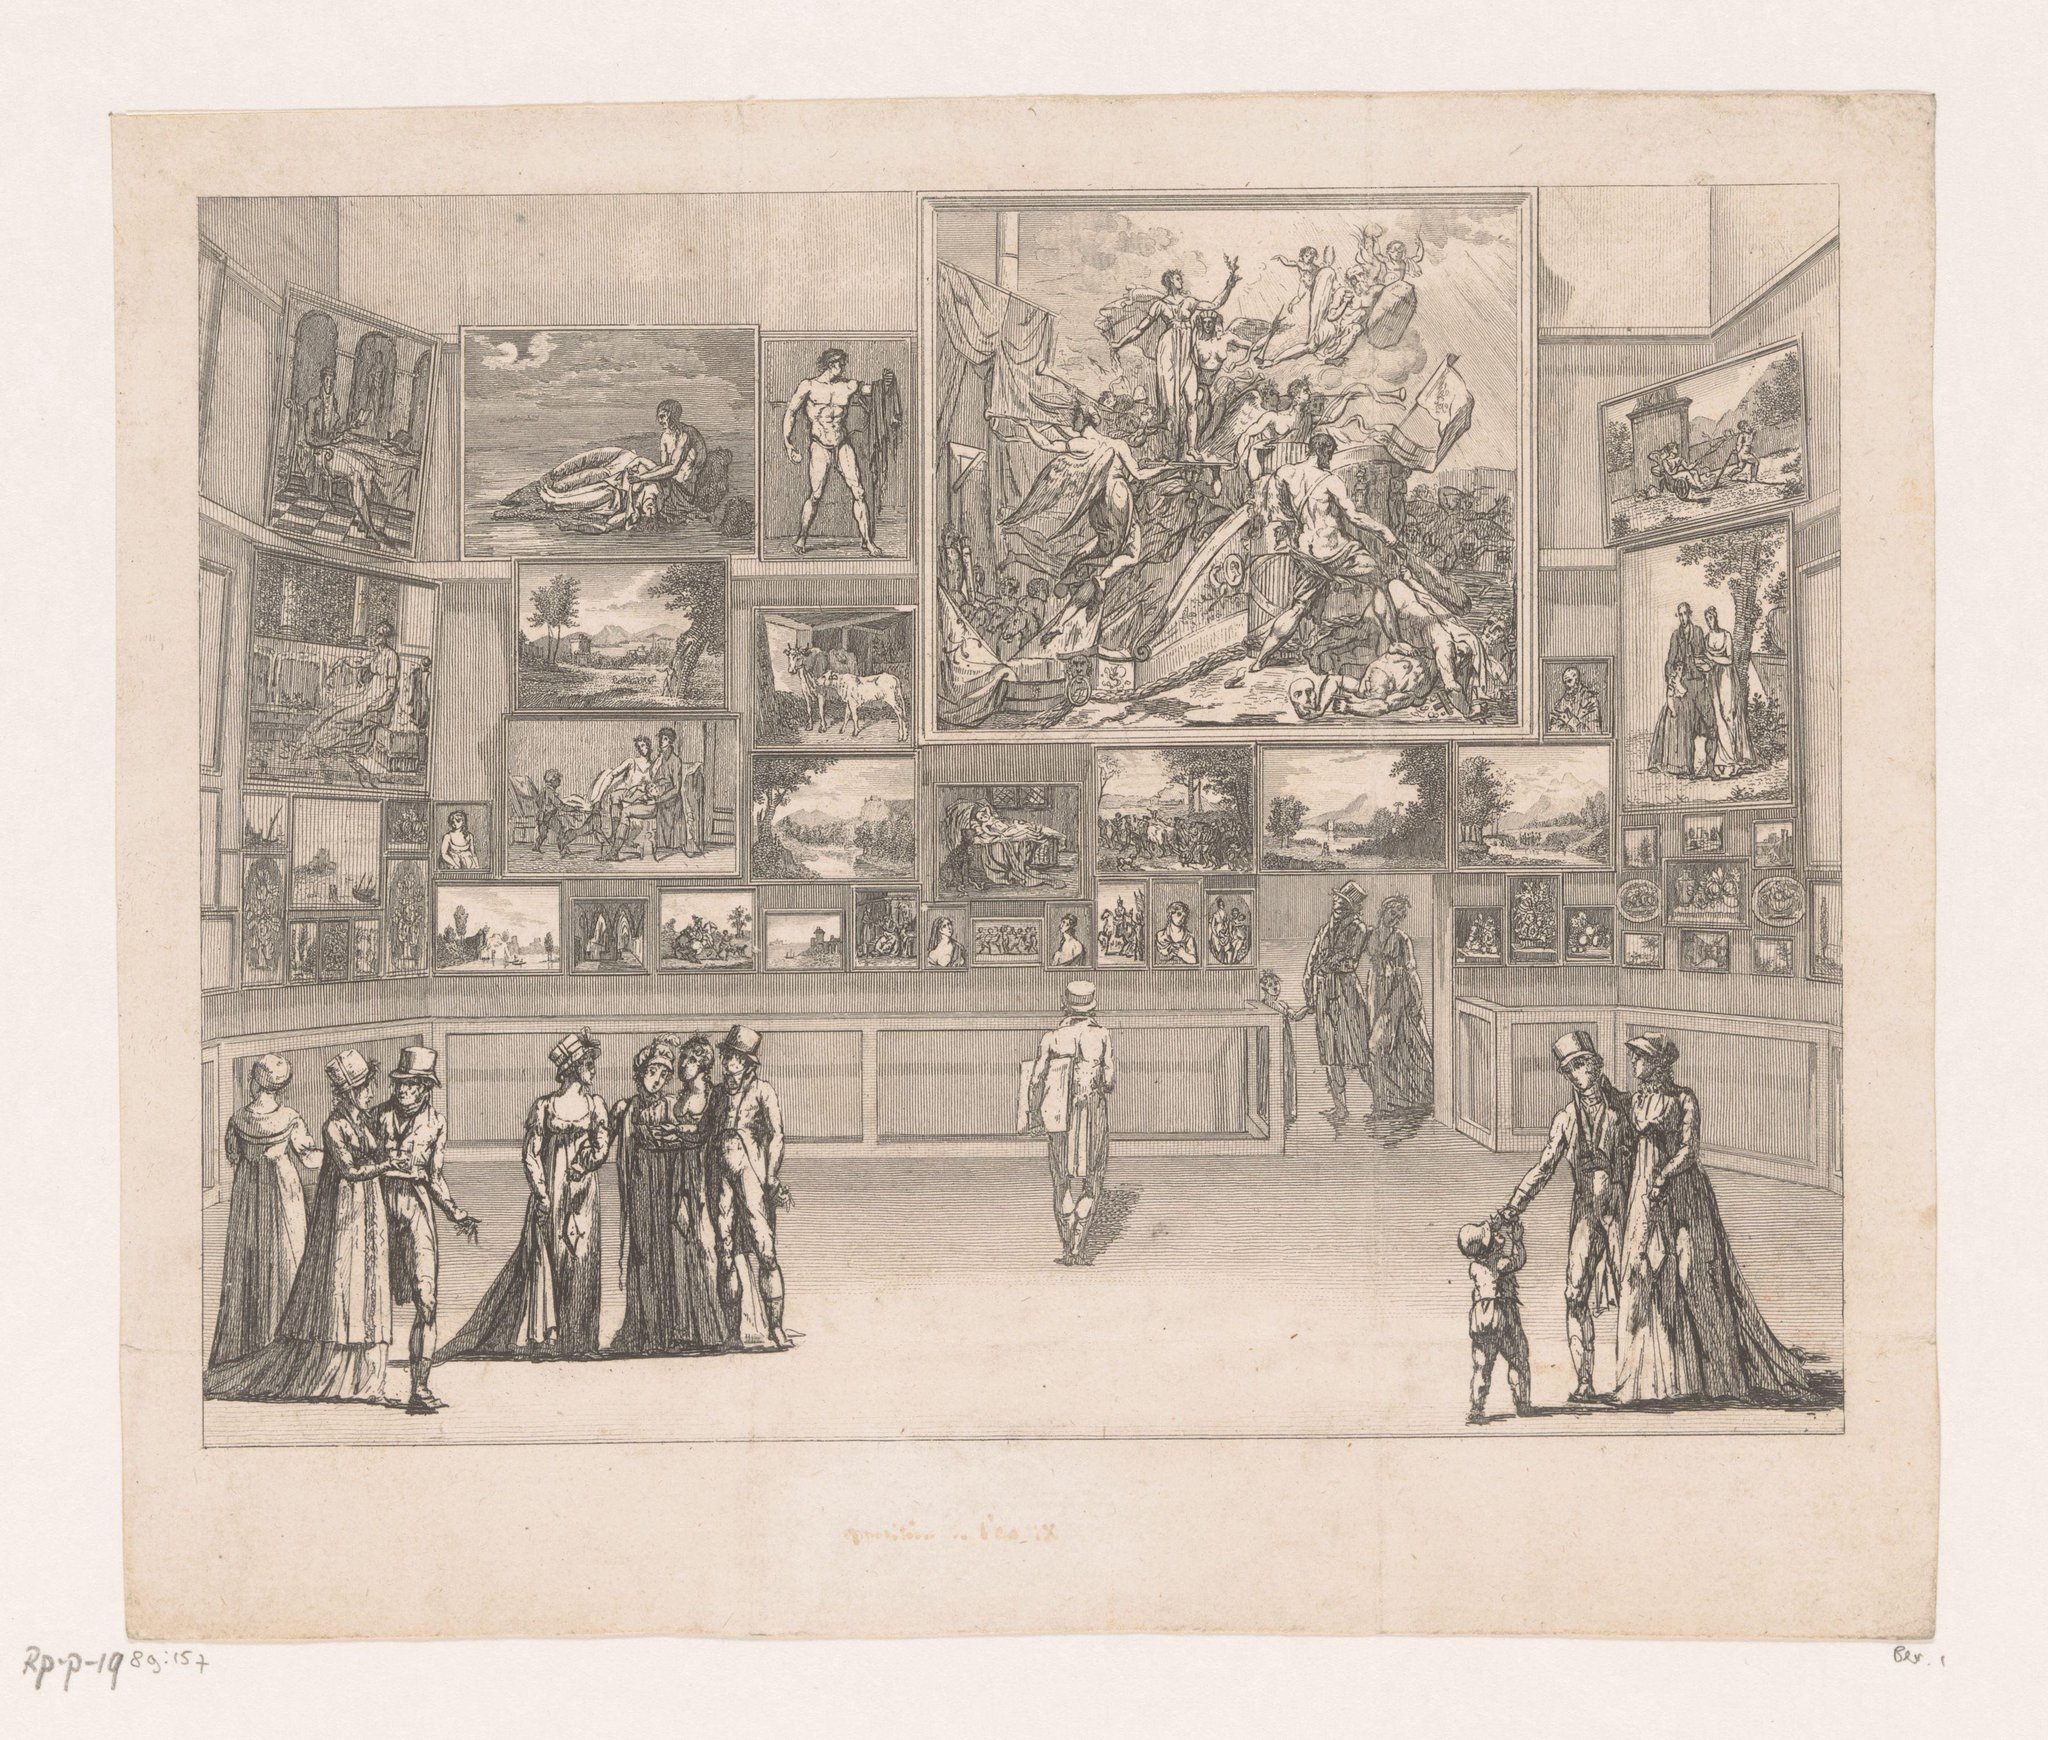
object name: print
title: Gezichten op schilderijengalerijen in het Musée du Louvre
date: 1800-1801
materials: paper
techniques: etching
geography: paris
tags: permanent exhibition, museum, picture, painting, 'gemalte galerie'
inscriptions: collector's mark: Lugt 2760, collector's mark: Lugt 2228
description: Monsaldy maakte verschillende gezichten op galerijen gedurende de Eerste Franse Republiek. Deze prent maakt deel uit van een vierdelige serie met gezichten op de schilderijengalerijen in het Musée du Louvre (Muséum central des arts de la République) van 1800-1801 (l'An IX).